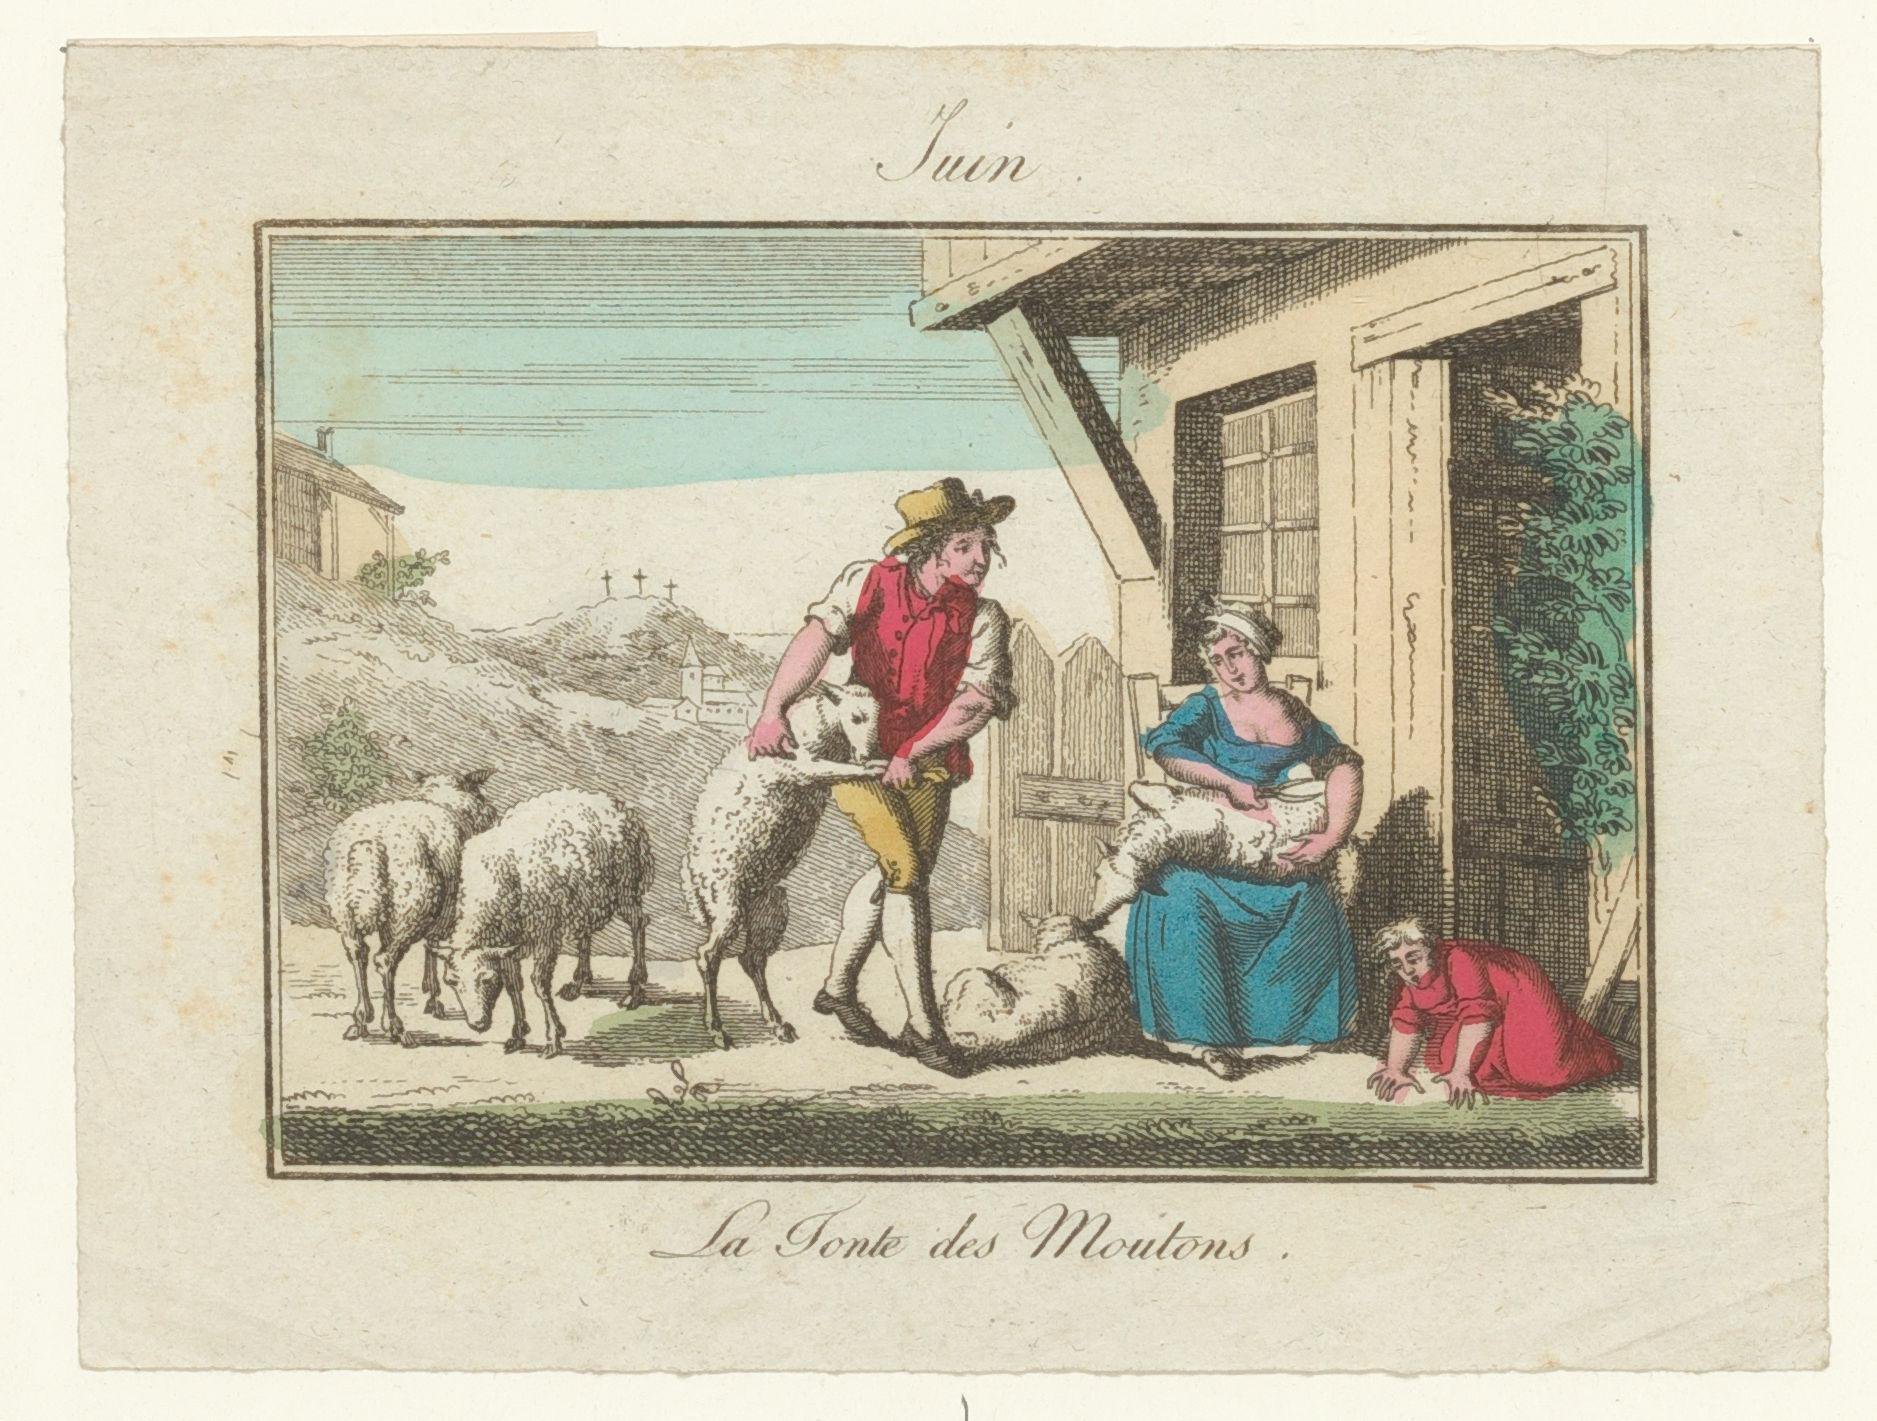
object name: print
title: Schapen scheren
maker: Anonymous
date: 1700-1799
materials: paper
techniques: etching, hand coloring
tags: sheep, shearing (sheep)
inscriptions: collector's mark: Lugt 1641, stamp:, stamp: Lugt 1641a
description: Een zittende vrouw knipt de vacht van een schaap. Een man komt met een volgend schaap aangelopen. Onderwerpsrubrieken binnen de Atlas Zeden en Gewoonten: Handel, Nijverheid en Verkeer, Beroep en bedrijf, Complete suites.